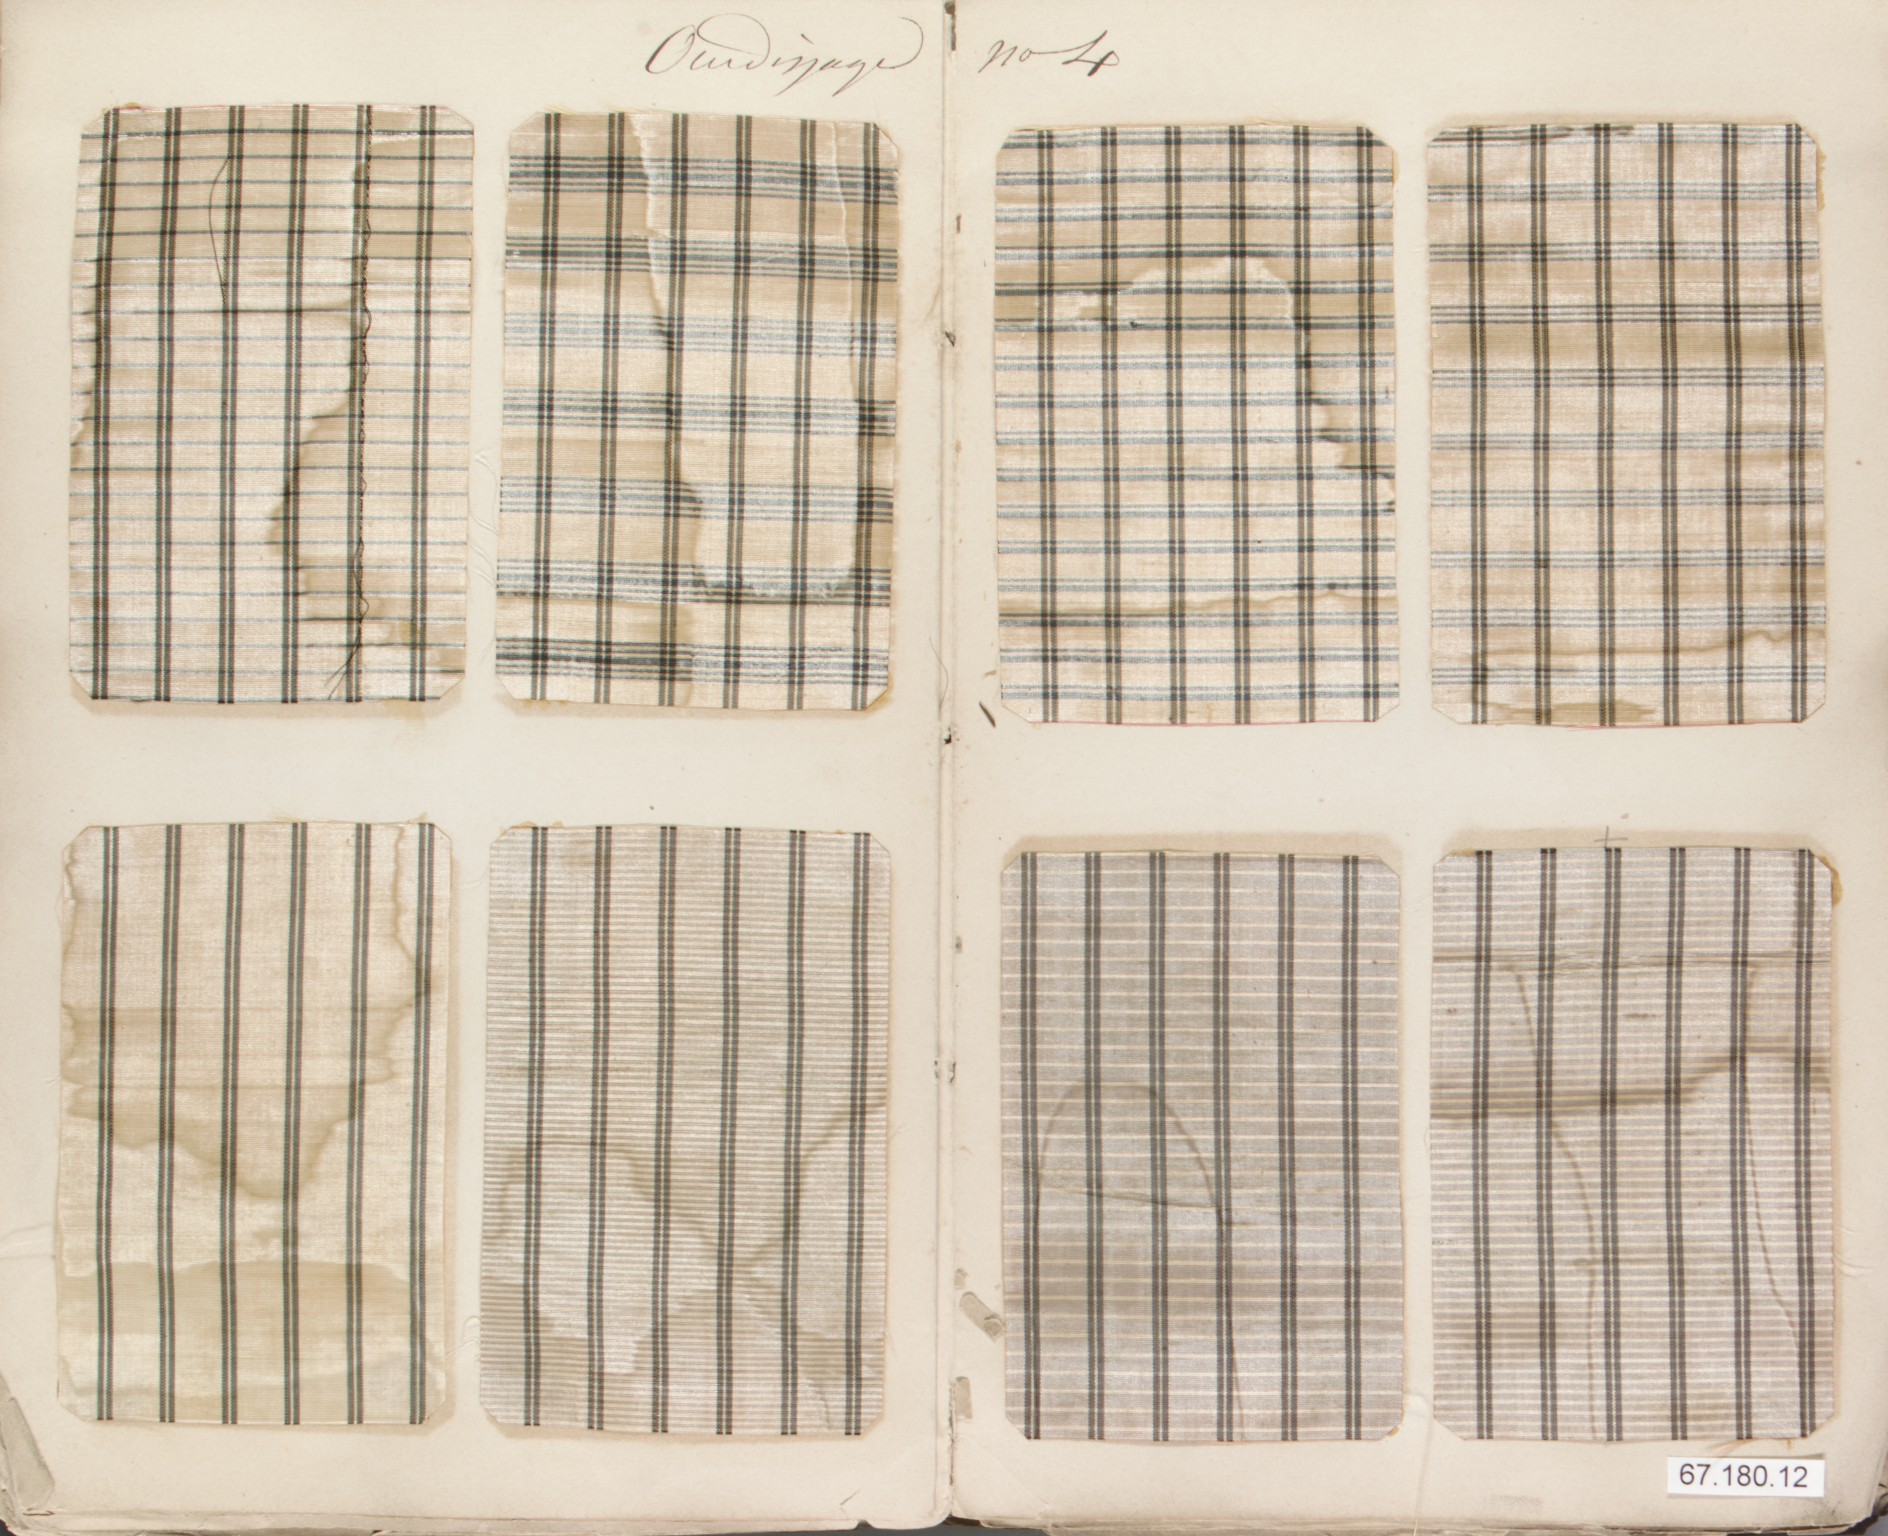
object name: sample book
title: Textile Sample Book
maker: m. coudurier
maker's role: maker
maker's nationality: french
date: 1849-1863